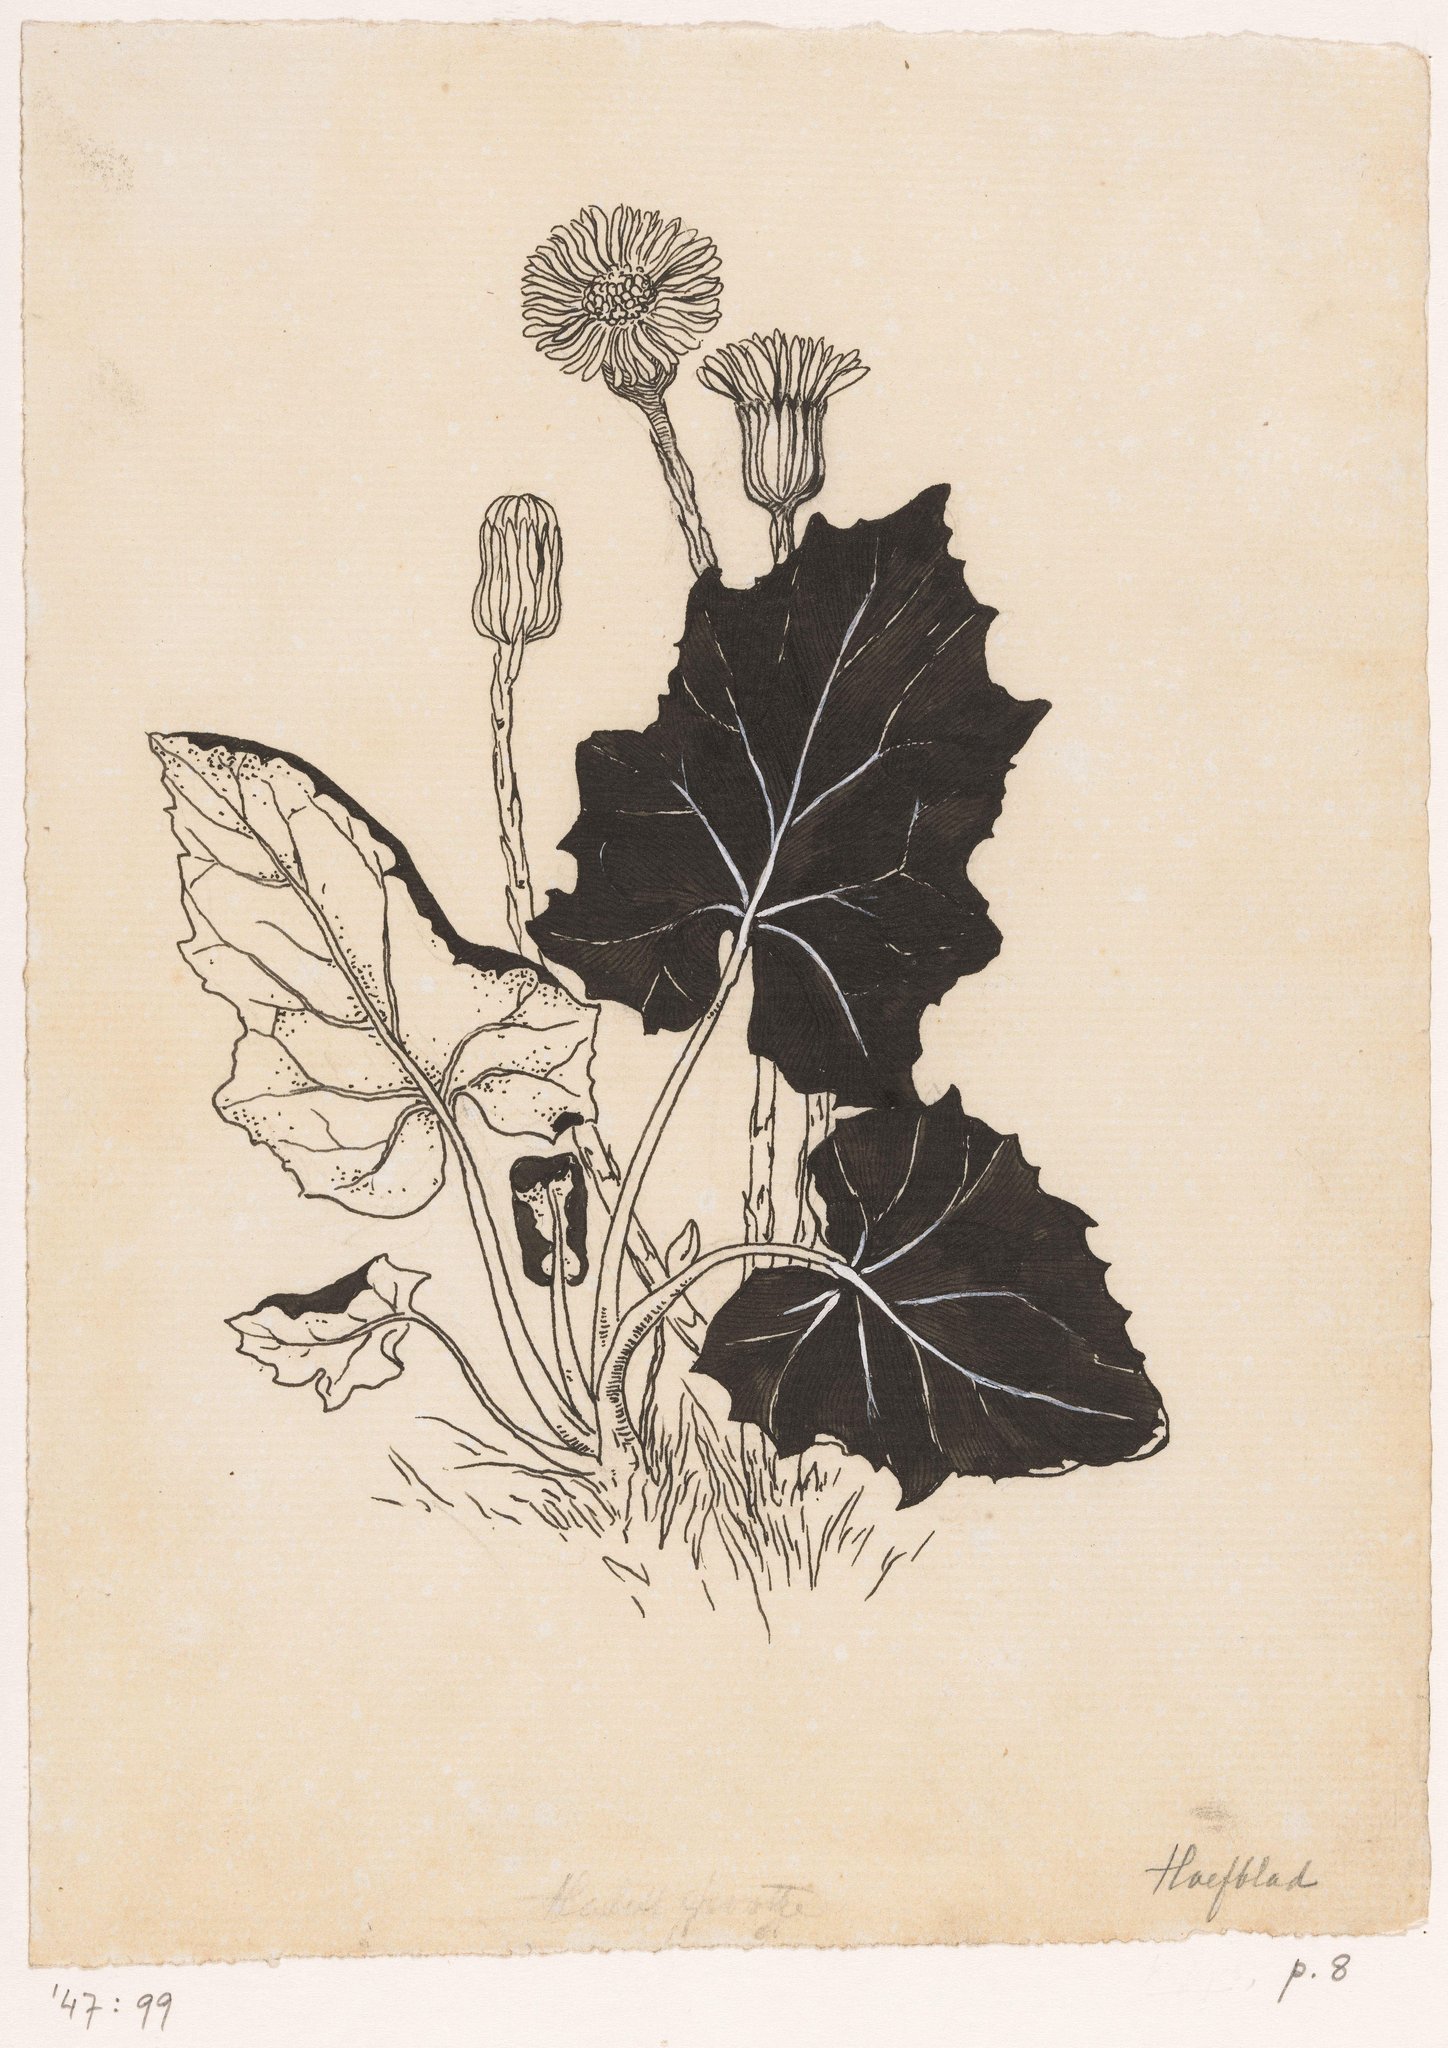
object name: drawing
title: Hoefblad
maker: willem wenckebach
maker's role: designer, draughtsman, painter, print maker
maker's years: 1860-1937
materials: paint, ink, paper, pencil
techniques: brush, pen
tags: plants (in general)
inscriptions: collector's mark: Lugt 2228a, annotation: ‘Hoefblad’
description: Ontwerp voor: Knappert, Emilie C. Kijkjes in de plantenwereld. Loman & Funke: Amsterdam, 1893.